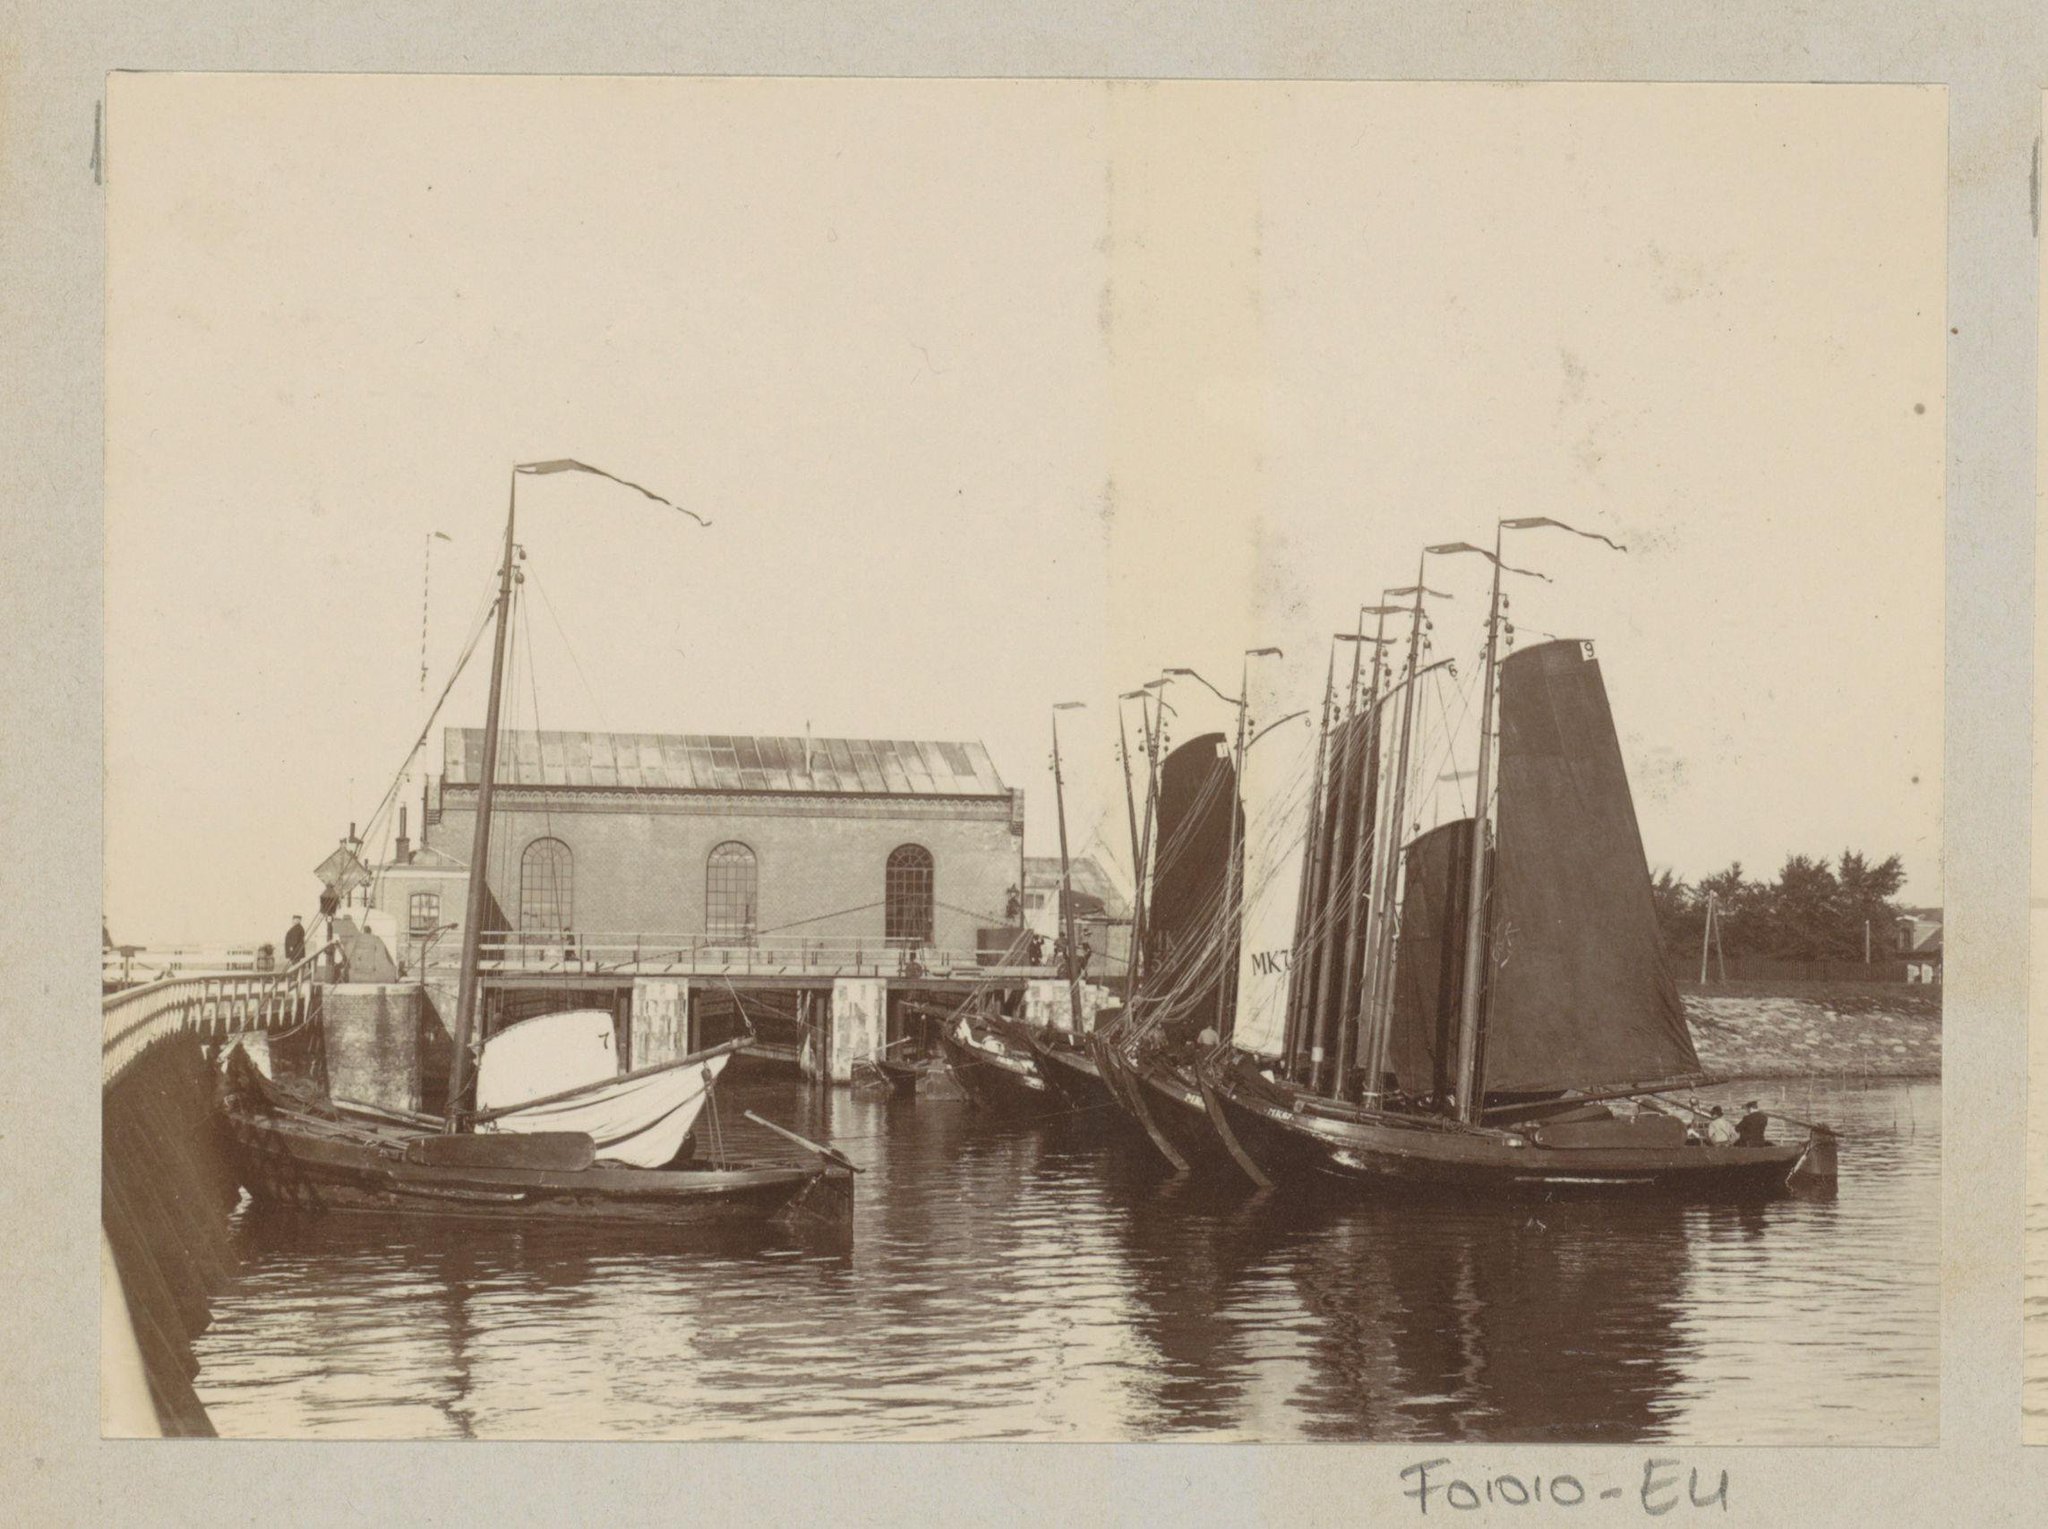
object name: photograph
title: Aangemeerde zeilschepen bij de Oranjesluizen in Amsterdam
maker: Anonymous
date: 1900-1910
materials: photographic support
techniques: daylight paper print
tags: sluice, weir, sailing-ship, sailing-boat, landscapes with waters, waterscapes, seascapes (in the temperate zone)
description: Onderdeel van Familiealbum met onder meer foto's van Wijnhandel Kraaij & Co. Bordeaux-Amsterdam.